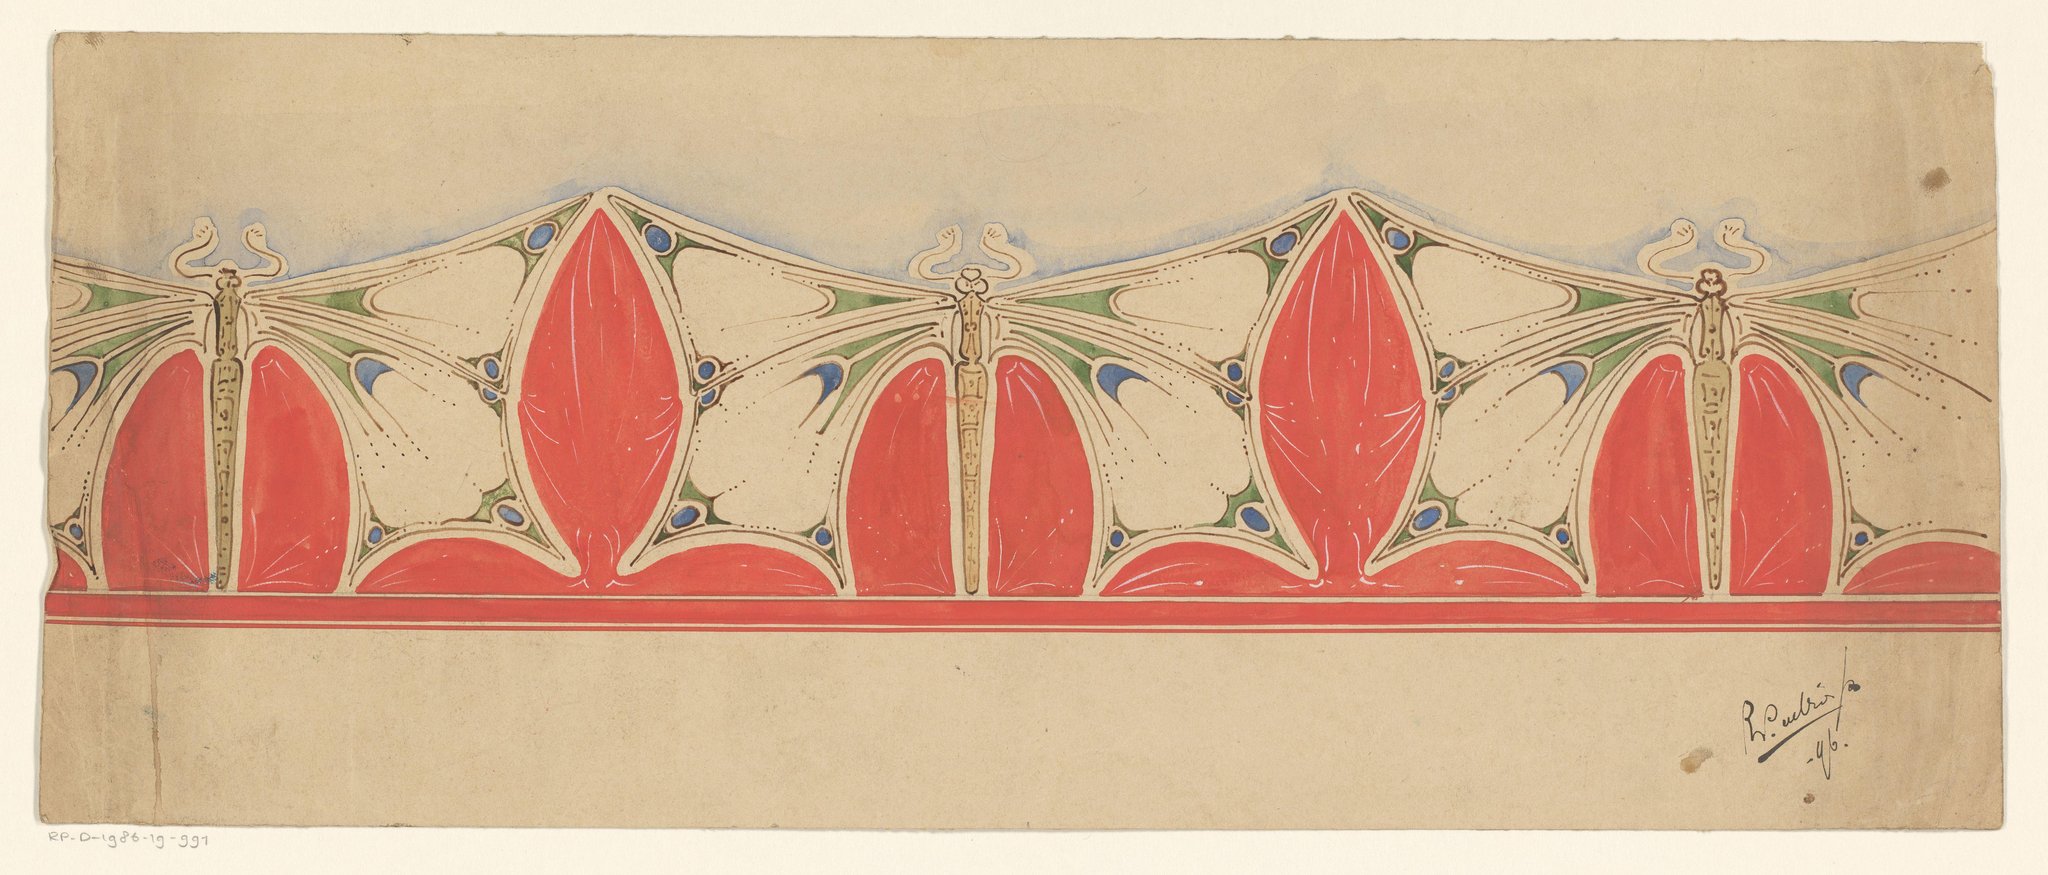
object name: drawing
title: Sierrand met patroon van vlinders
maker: reinier willem petrus de vries (1874-1953)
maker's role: draughtsman, print maker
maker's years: 1874-1953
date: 1896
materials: paint, ink, paper, pencil, watercolor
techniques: brush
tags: insects: butterfly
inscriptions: collector's mark: ‘R:MVS.’, signature and date: ‘RwP. deVries Jr/ -96.’